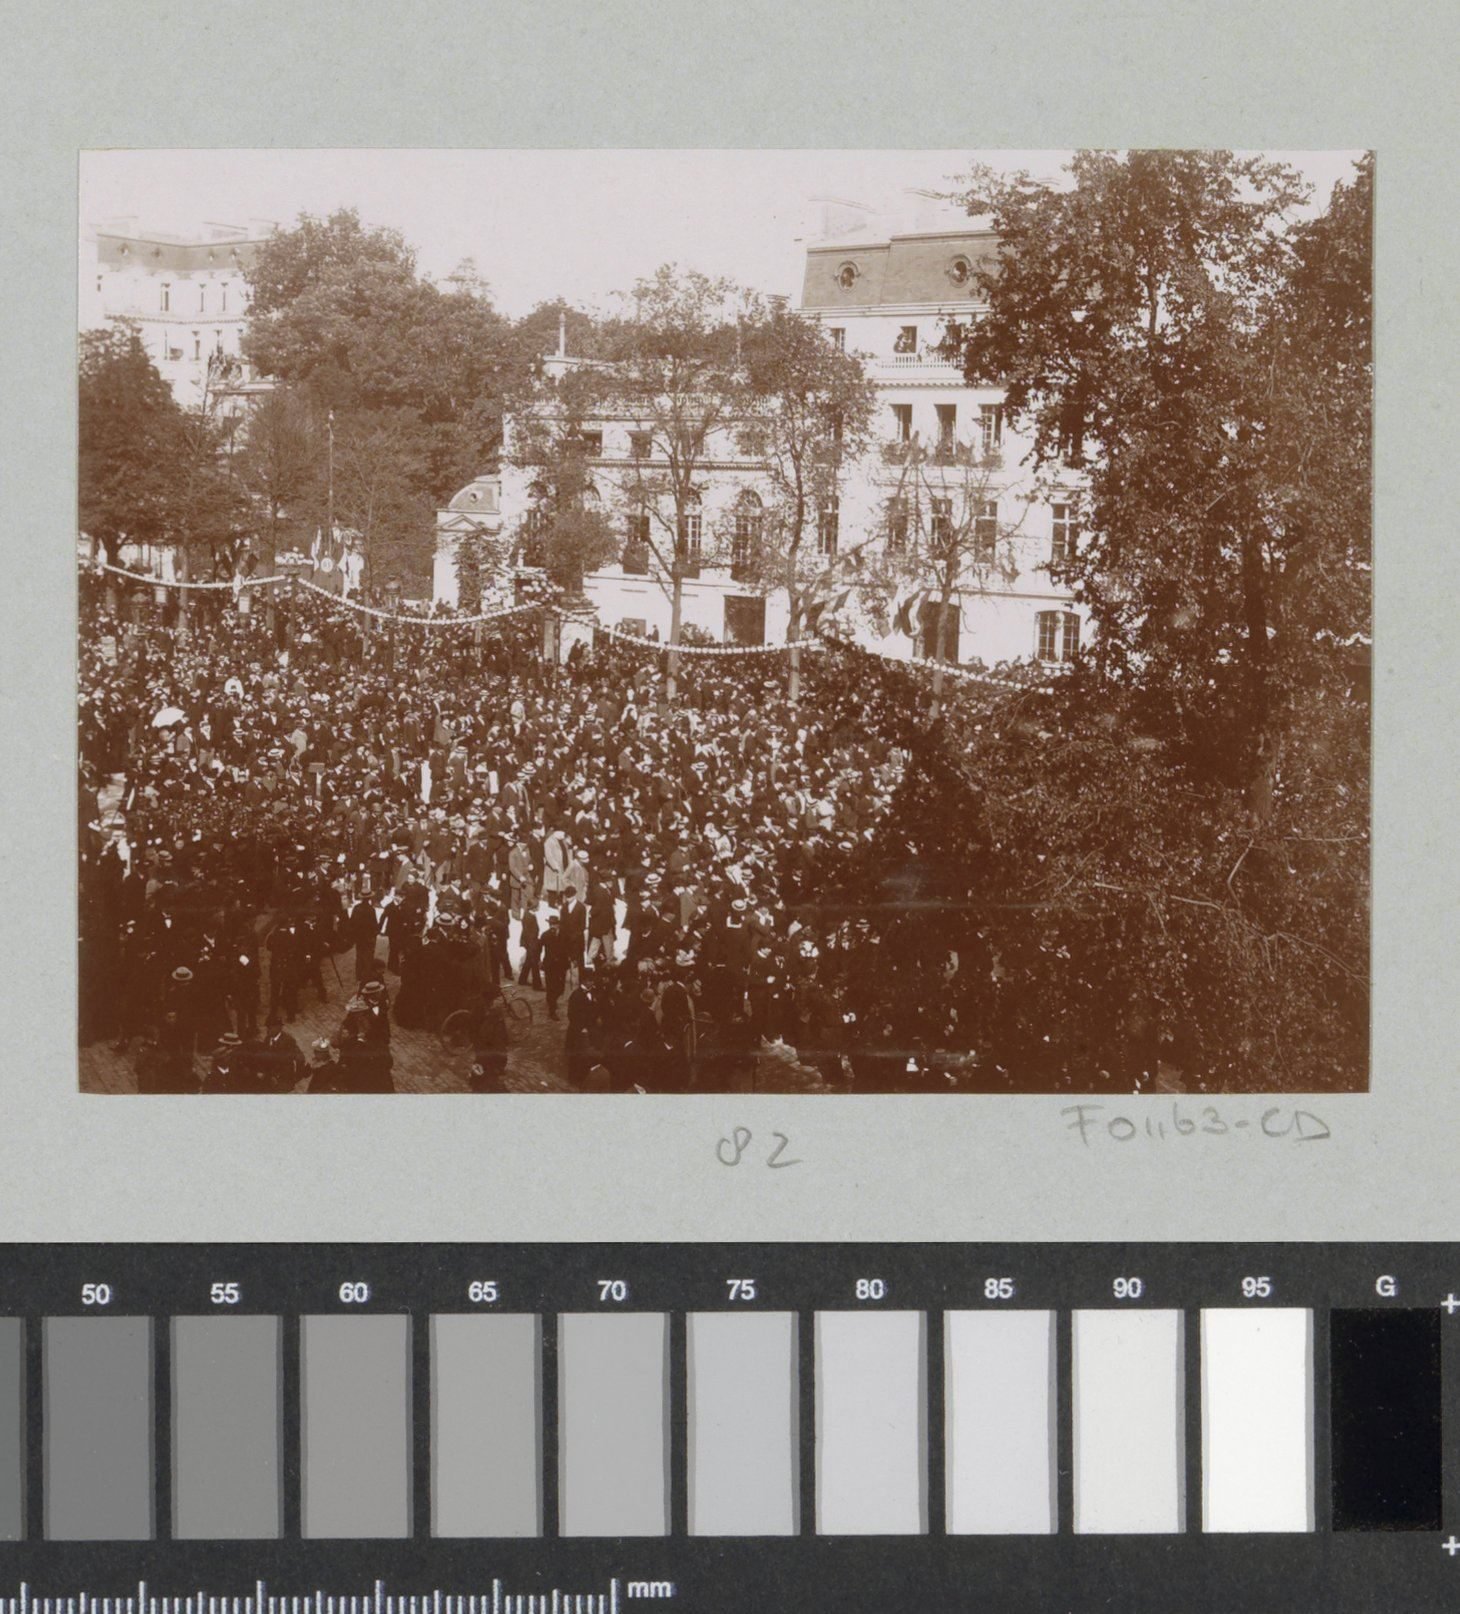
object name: photograph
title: Menigte op straat bij het bezoek van tsaar Nicolaas II van Rusland aan Parijs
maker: delizy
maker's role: manufacturer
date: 1896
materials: paper, photographic support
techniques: gelatin silver print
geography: paris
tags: land forces (+ cavalry, horsemen), crowd, mob, festivities (+ parade, pageant, cavalcade ~ festive activities), paris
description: Onderdeel van Fotoalbum van een Franse amateurfotograaf met opnames van uitstapjes in Frankrijk, Spanje, België, Luxemburg en Nederland, de eerste automobielen en autoraces.